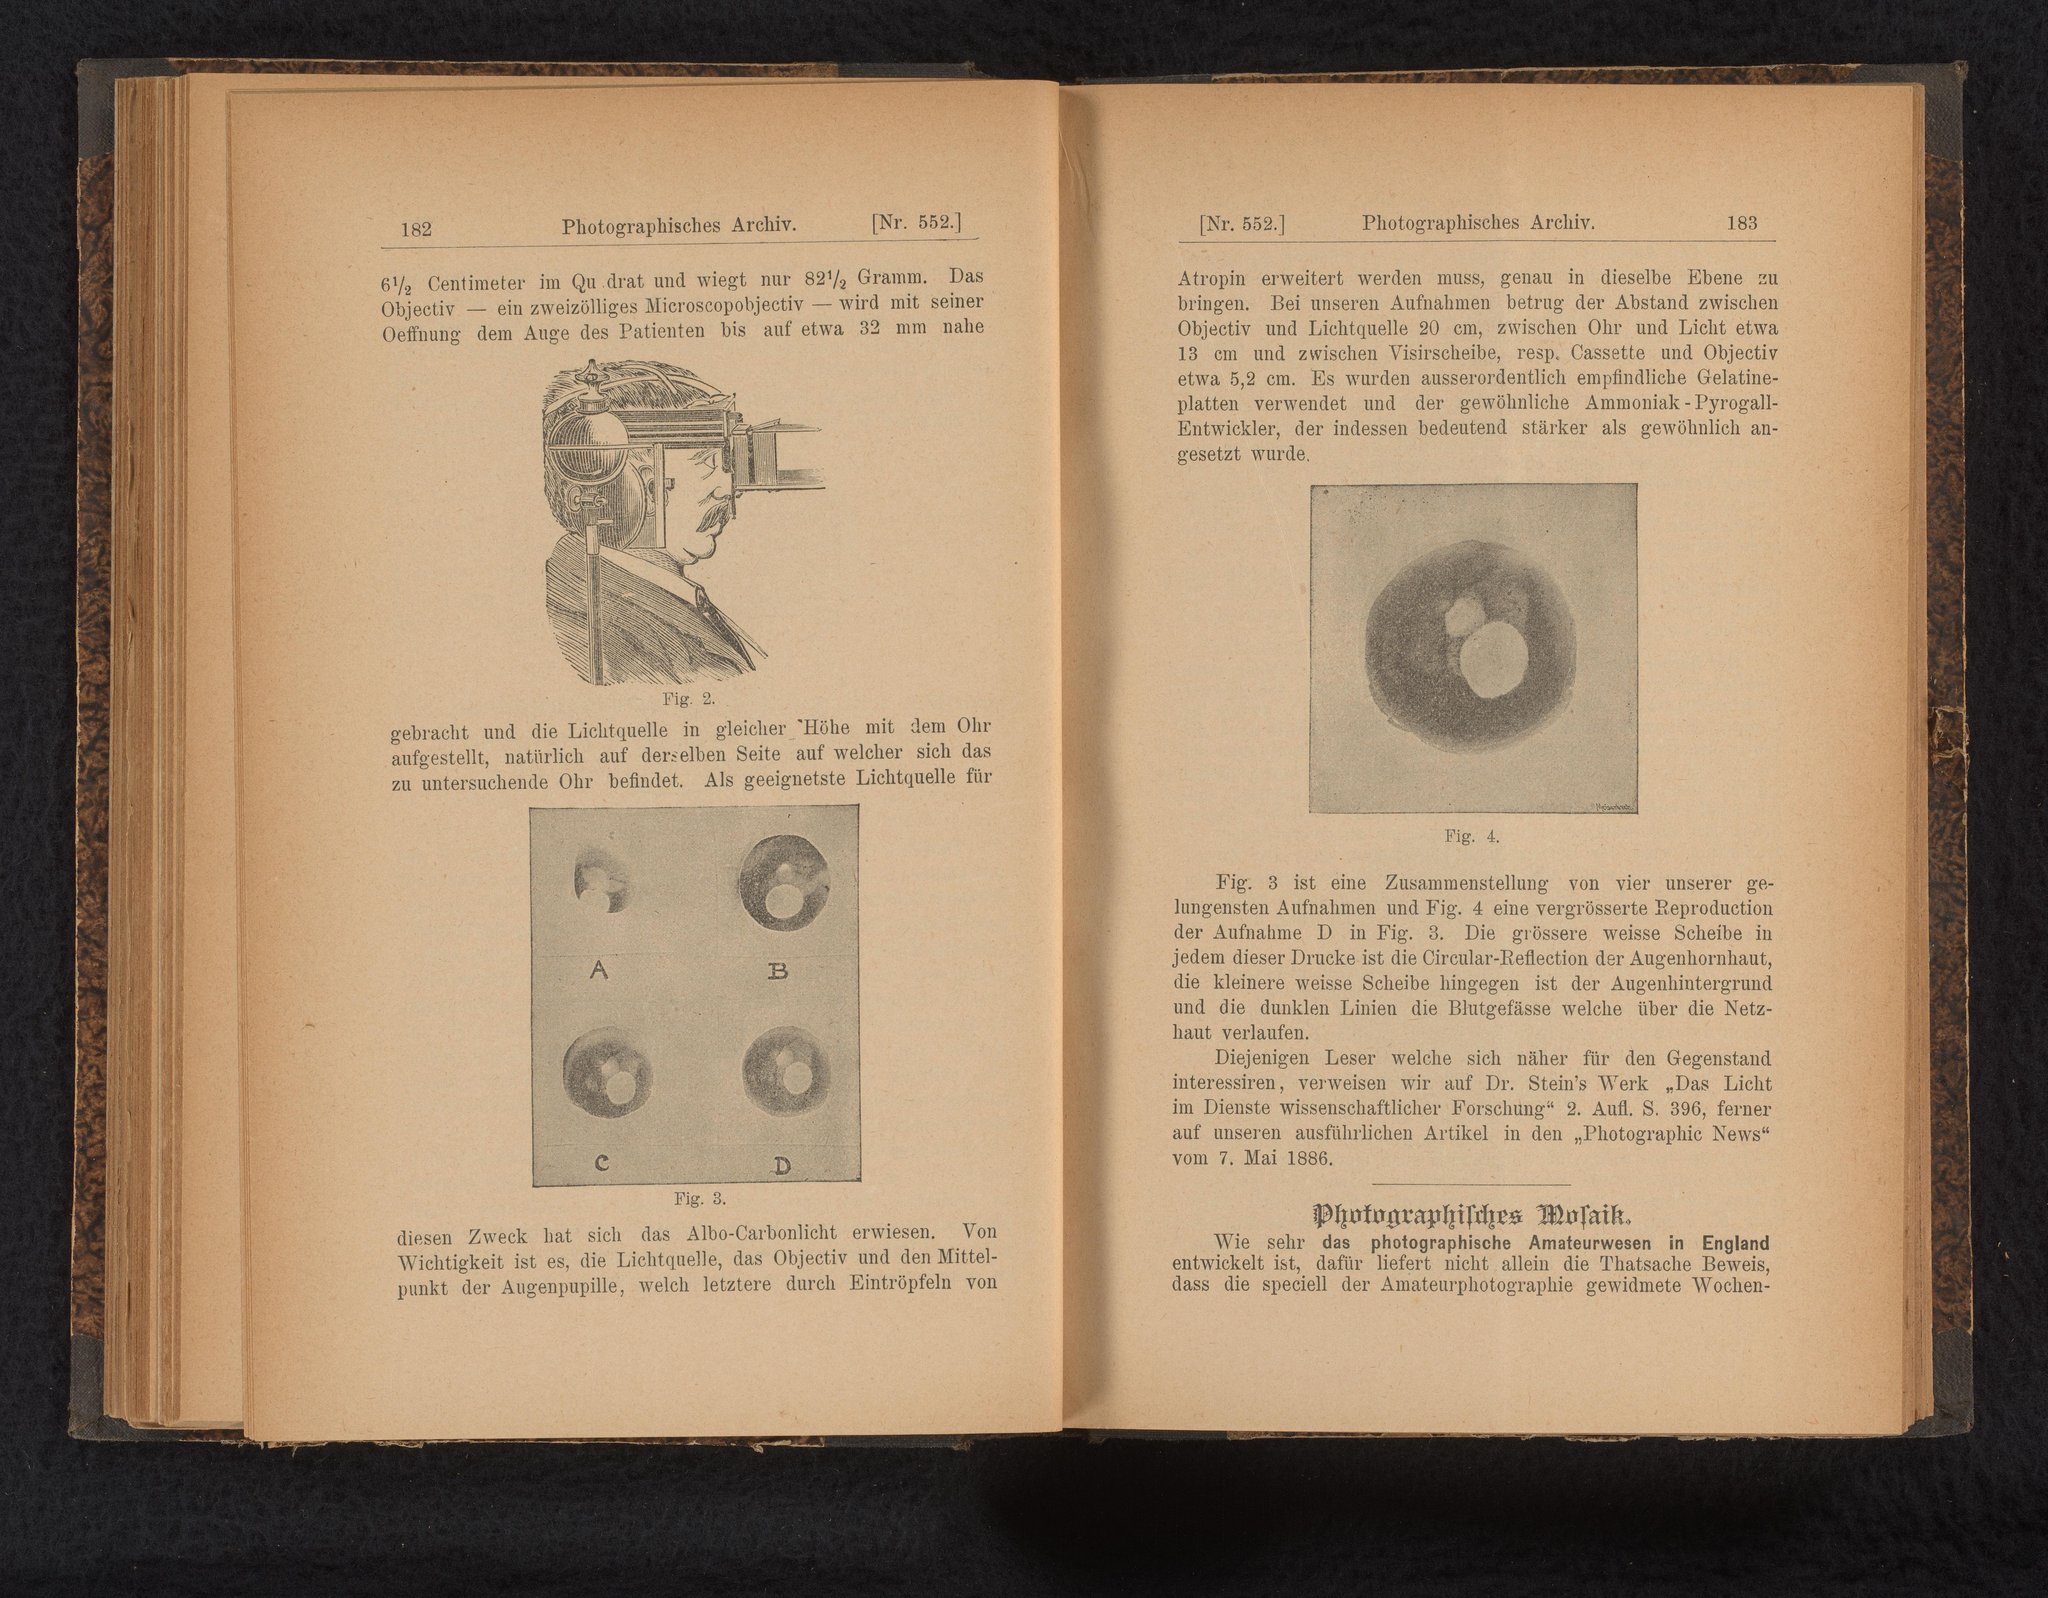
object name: page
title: Microscopische opnamen van het menselijk oog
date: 1885-1886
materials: paper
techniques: autotype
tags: eyes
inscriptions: inscription: ‘Fig. 4.’